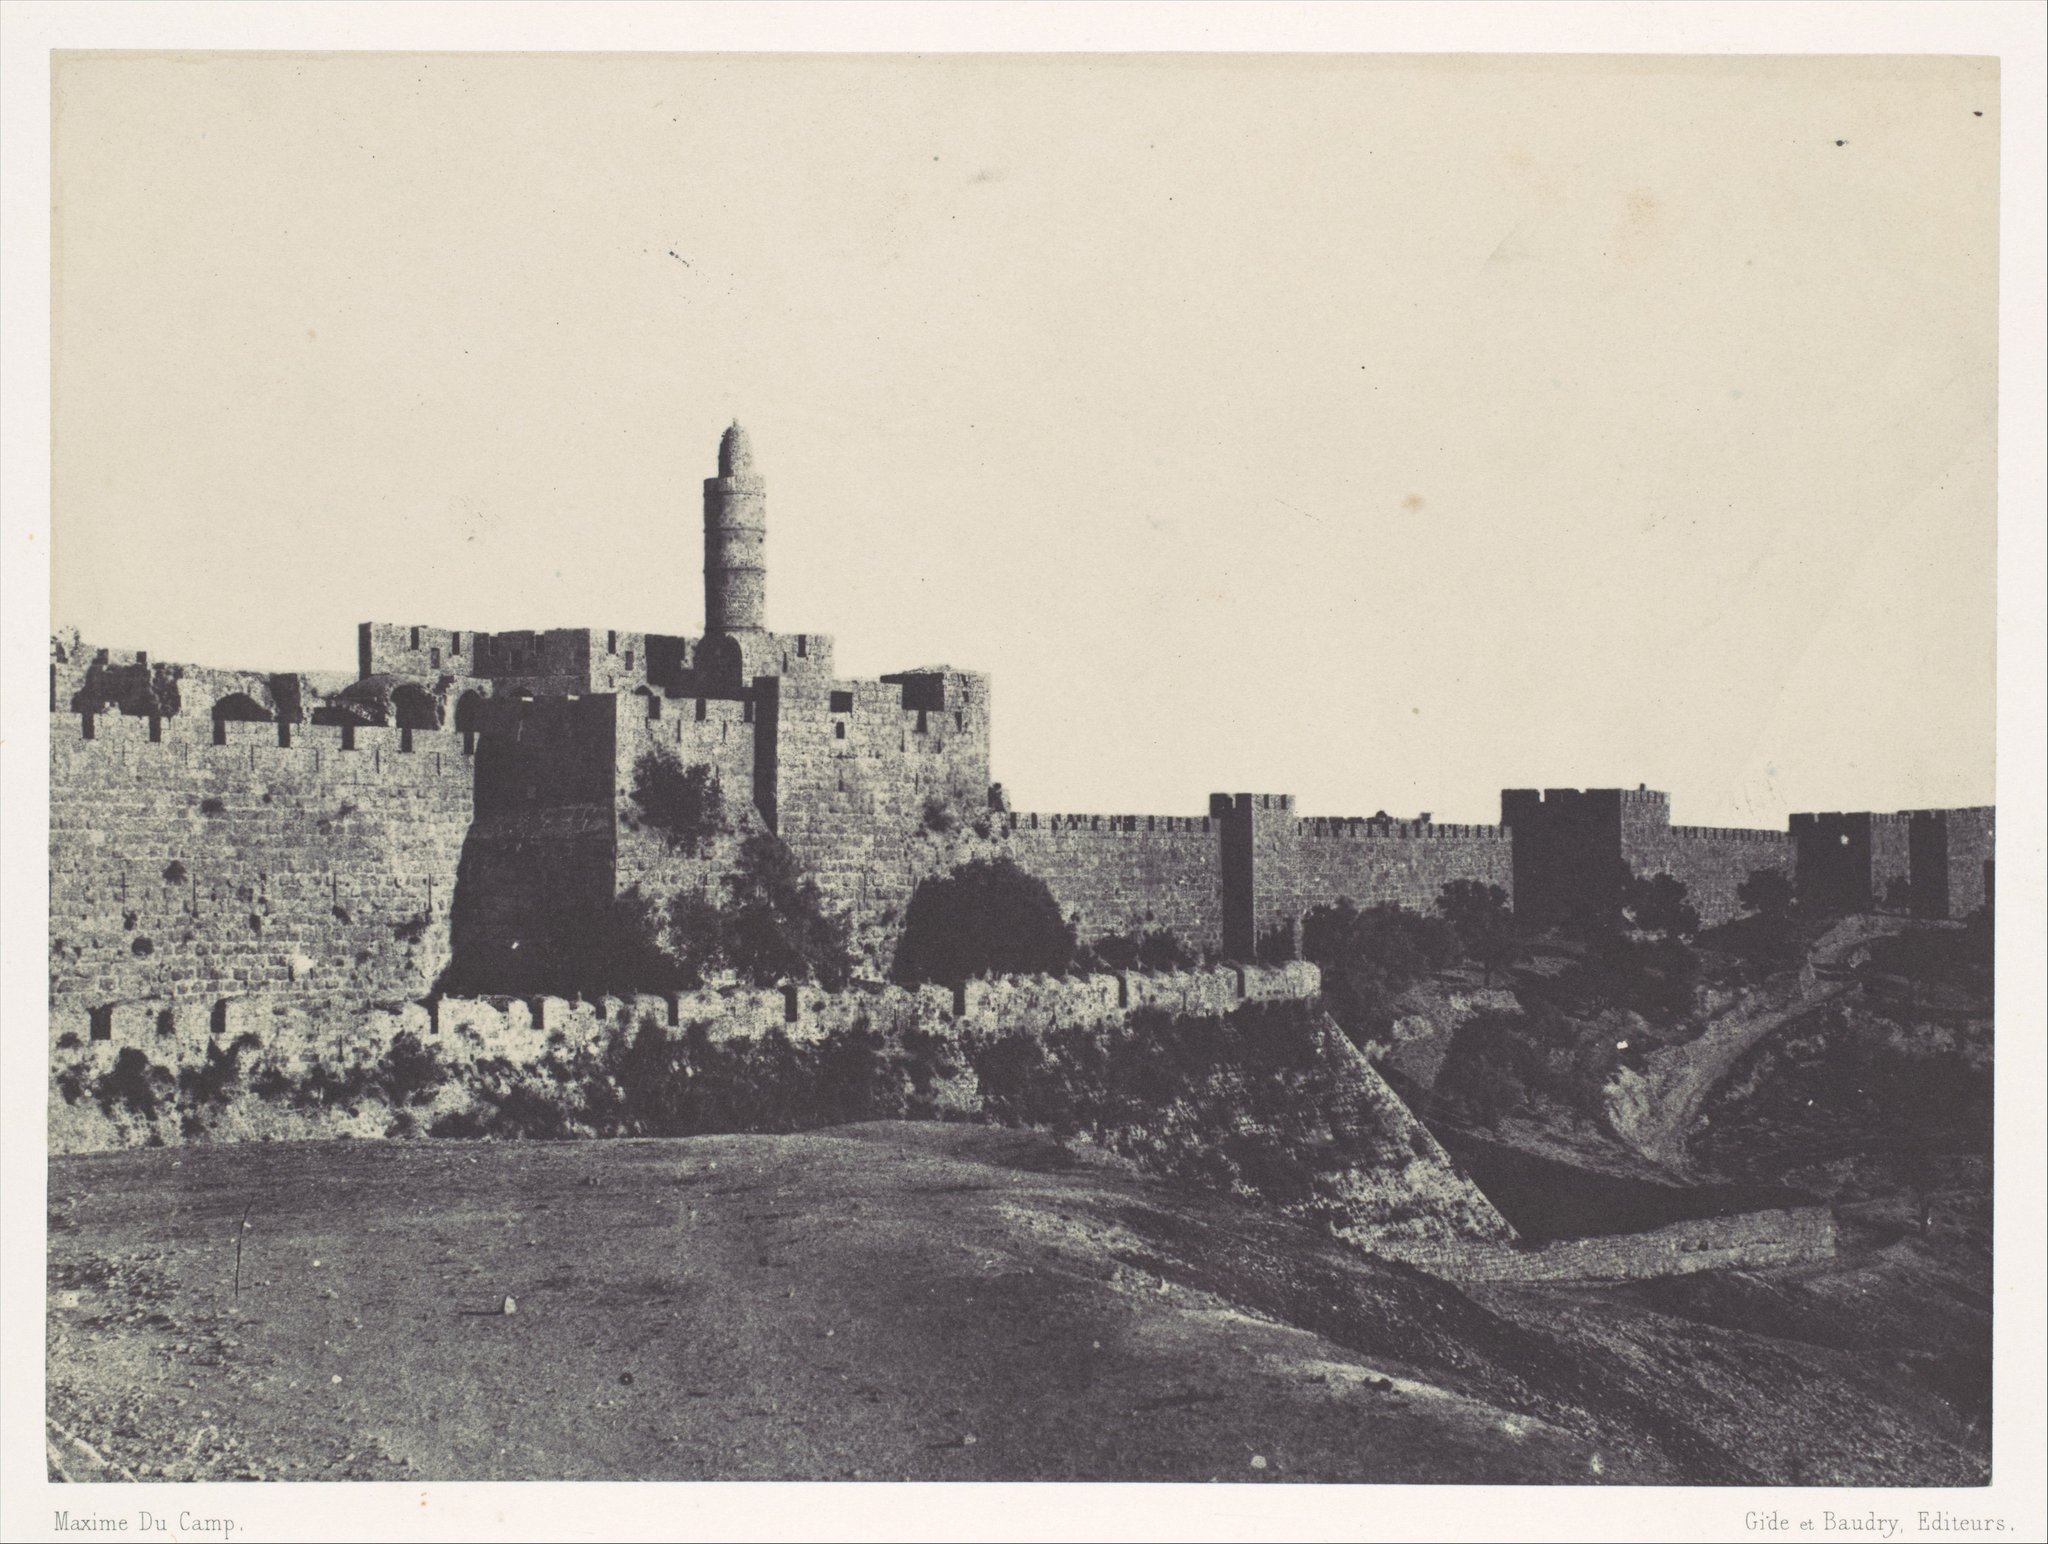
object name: photograph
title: Palestine. Jérusalem. Partie occidentale des Murailles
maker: maxime du camp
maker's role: artist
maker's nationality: french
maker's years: 1822-1894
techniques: paper negative, salted paper print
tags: architecture